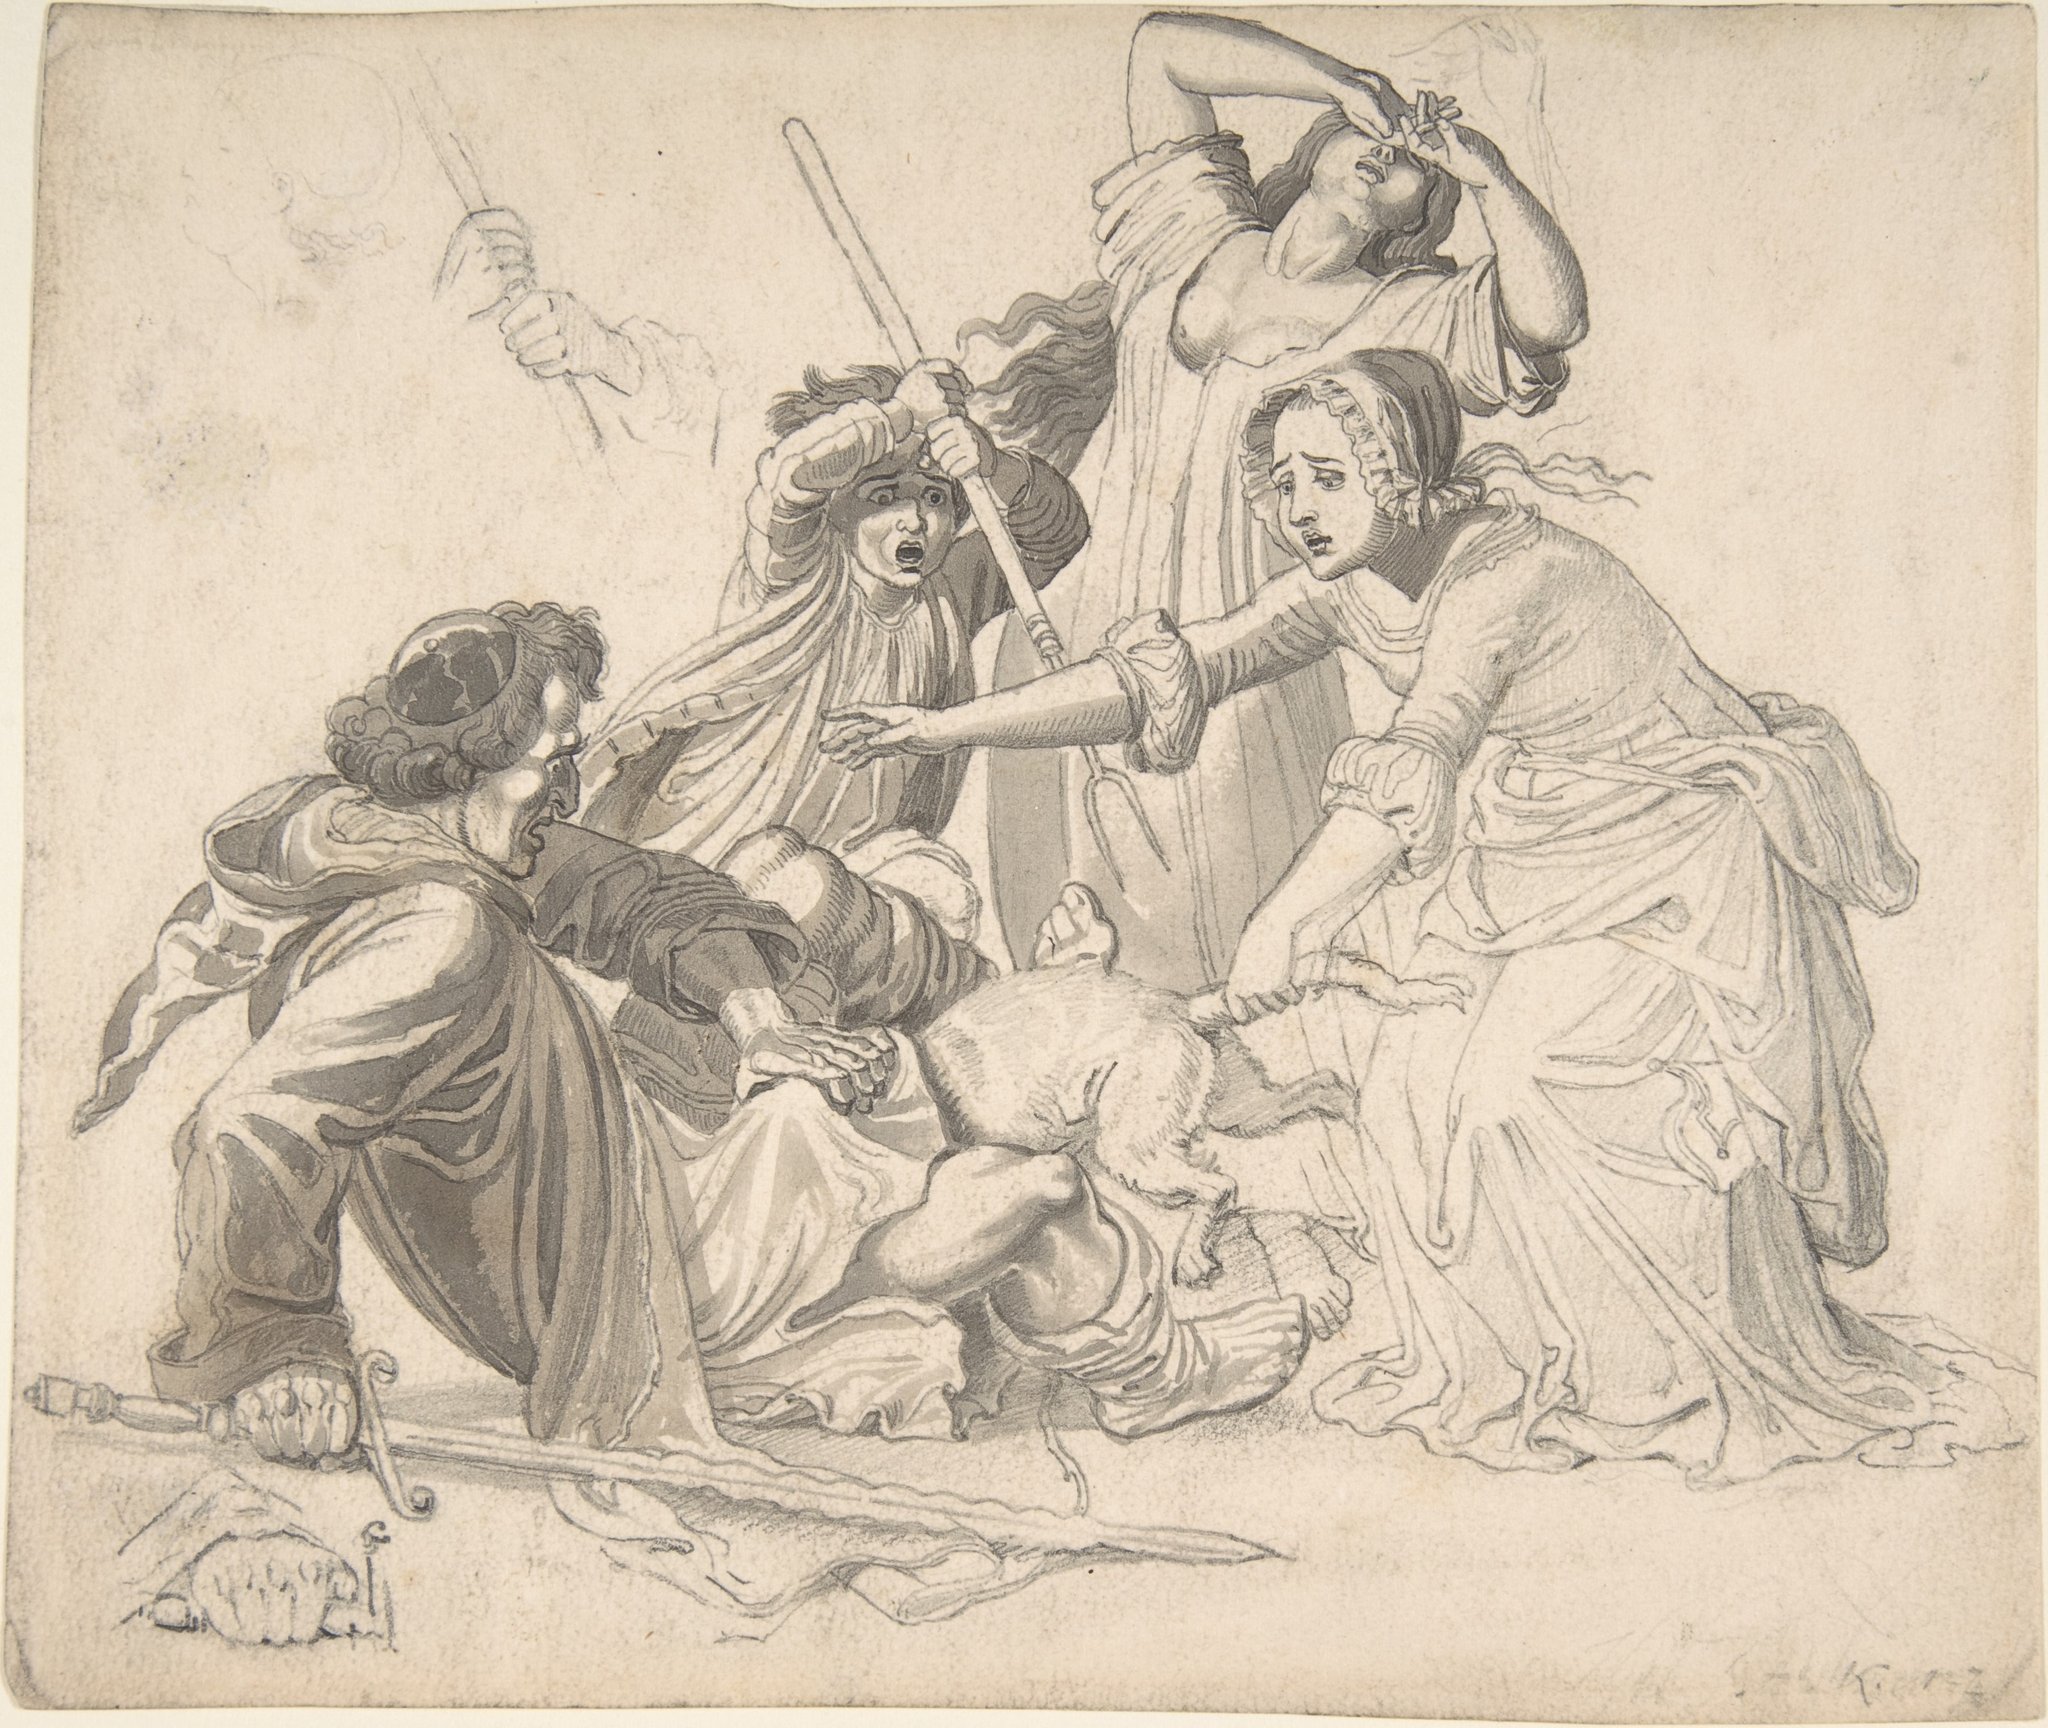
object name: drawing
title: Illustration for Reinecke Fuchs: Tomcat Hinz being hit instead of Reinecke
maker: wilhelm von kaulbach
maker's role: artist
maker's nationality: german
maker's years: 1804-1874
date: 1805-1874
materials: graphite, ink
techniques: brush, pen, wash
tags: animals,swords,men,women